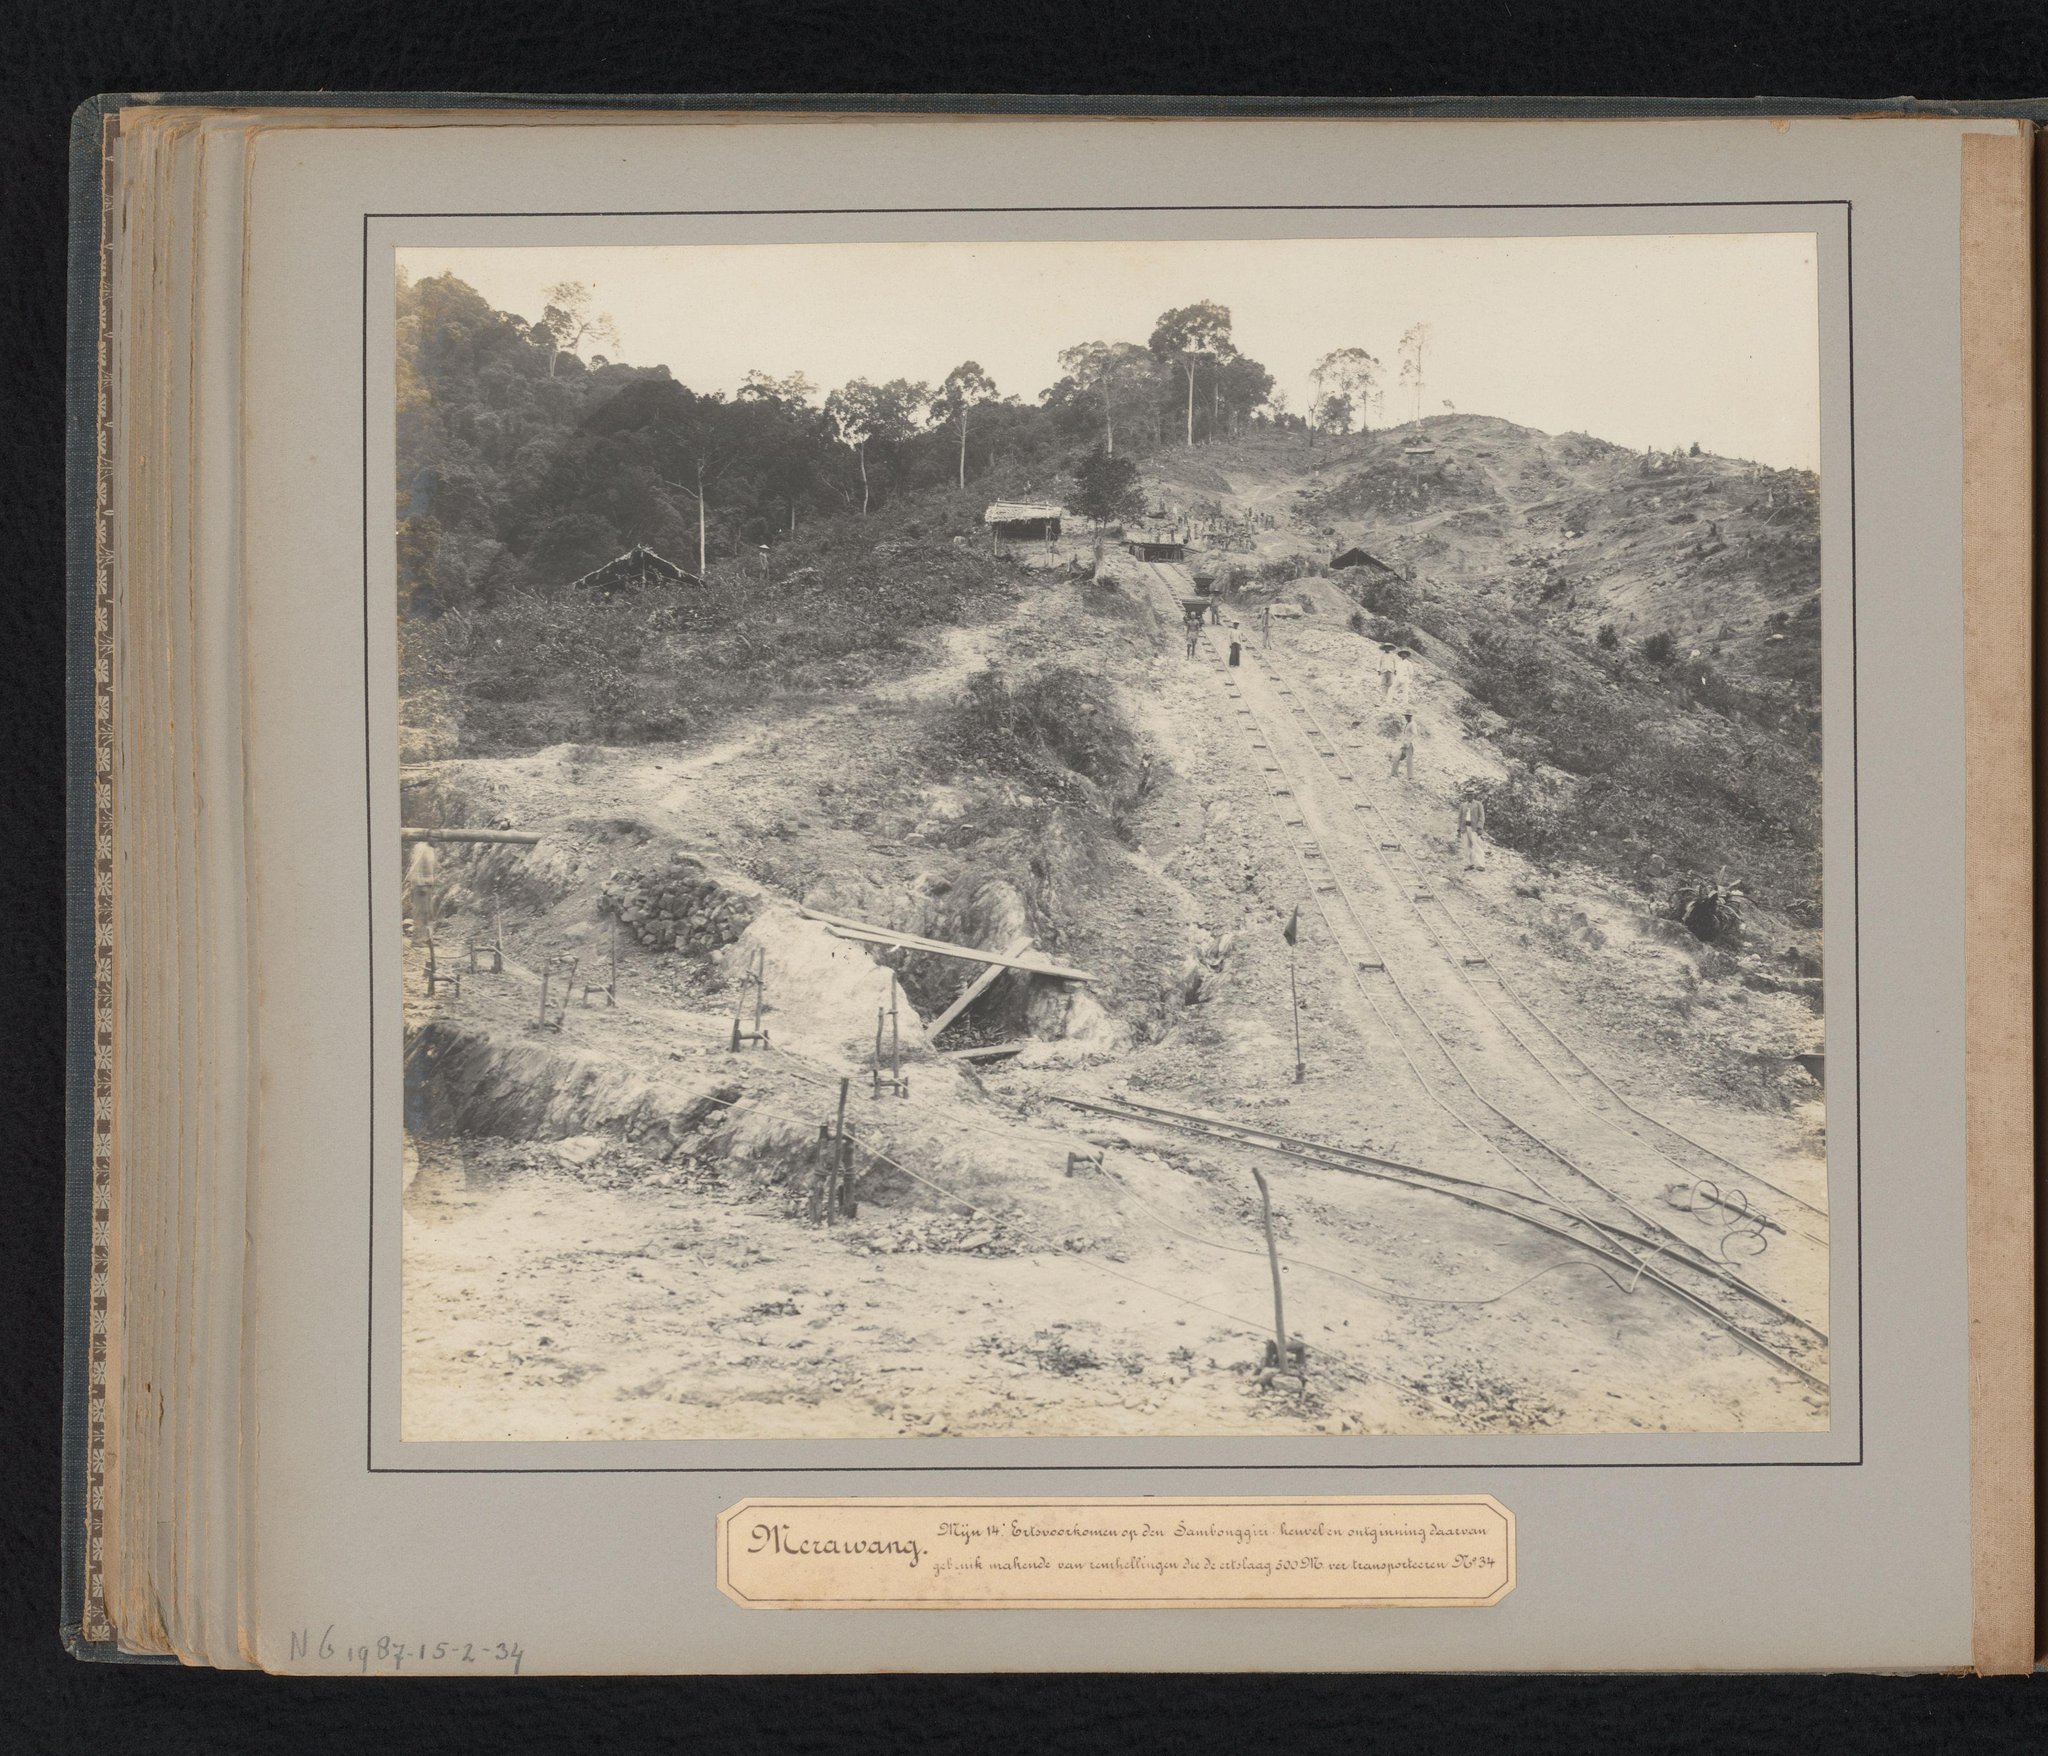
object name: photograph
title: Merawang. Mijn 14. Ertsvoorkomen op den Sambonggiri heuvel en ontginning daarvan gebruik makend van remhellingen die de ertslaag 500 M. ver transporteeren No. 34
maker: Anonymous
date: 1907-1919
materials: cardboard, photographic support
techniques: gelatin silver print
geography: bangka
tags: robert julius boers, colonial system, opencast mine; strip mining, minerals and metals: tin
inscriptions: label: ‘Merawang. Mijn 14. Ertsvoorkomen op den Sambonggiri heuvel en ontginning daarvan gebruik makend van remhellingen die de ertslaag 500 M. ver transporteeren No. 34’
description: Afvoer van ertsgrond met karretjes over spoorbaantjes met remblokken bij een tinmijn van de Banka-tinwinning op een heuvel te Merawang. Onderdeel van het fotoalbum over de Banka-tinwinning, ca. 1907-1919.